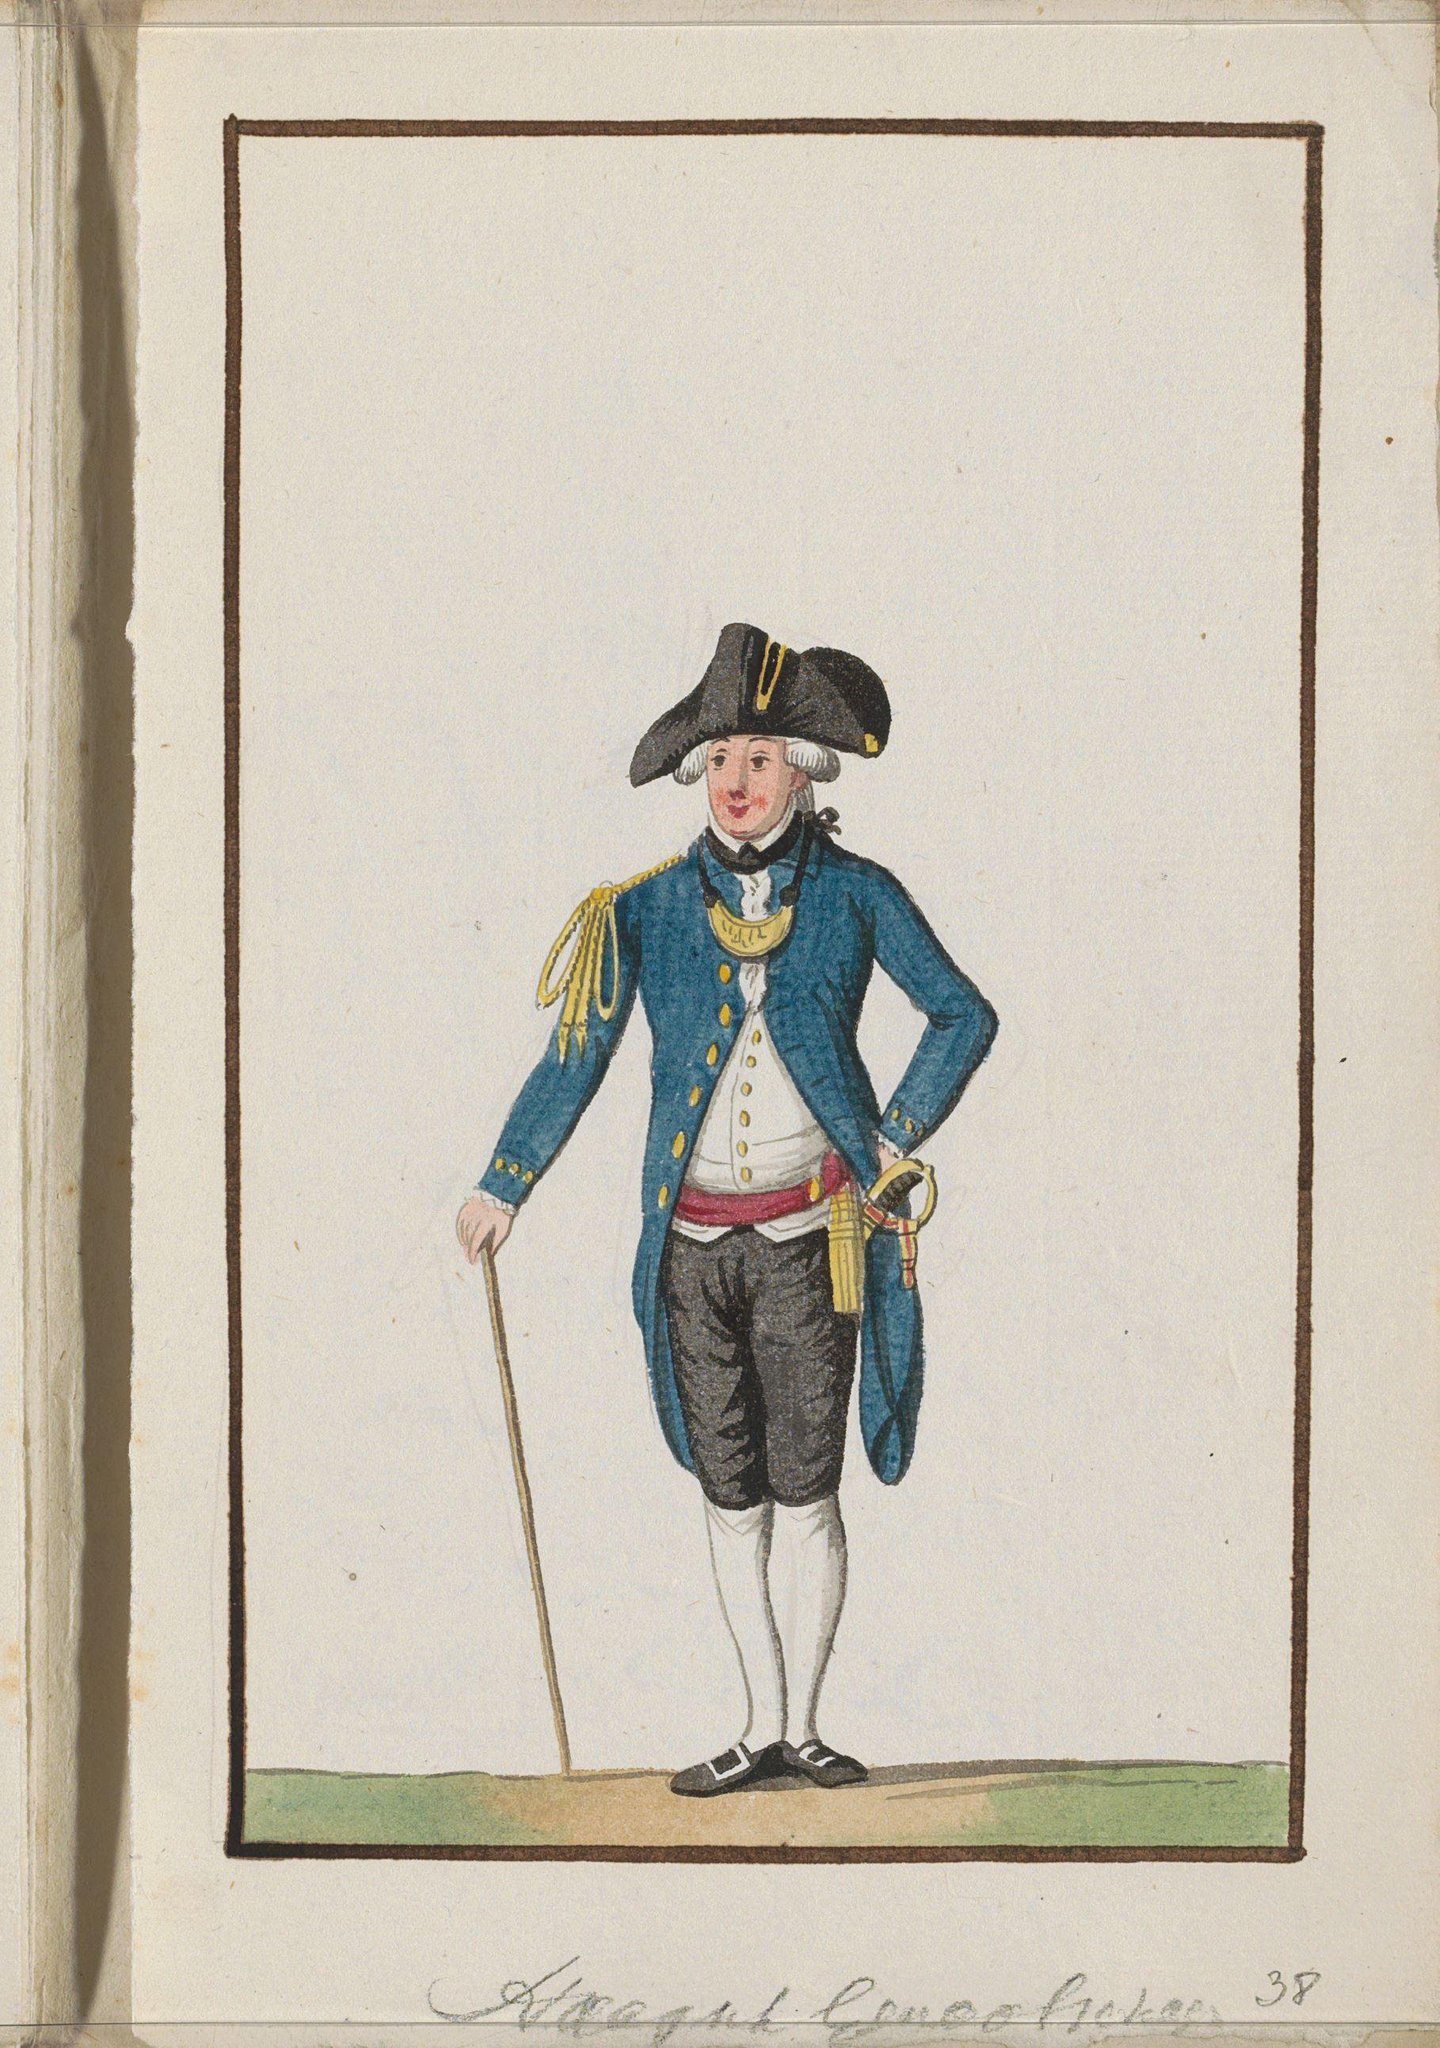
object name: drawing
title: haagse genootschap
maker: Anonymous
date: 1789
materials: paper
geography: northern netherlands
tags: (military) uniforms (+ citizen soldiery, civil guard, citizen militia), the hague, patriots (1780-1795)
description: Montering of uniform van het exercitiegenootschap van Den Haag, ca. 1785. Onderdeel van een schetsboek met 41 gekleurde tekeningen van de monteringen van de gewapende schutterijen en burgercorpsen in Nederland in de periode ca. 1783-1789.